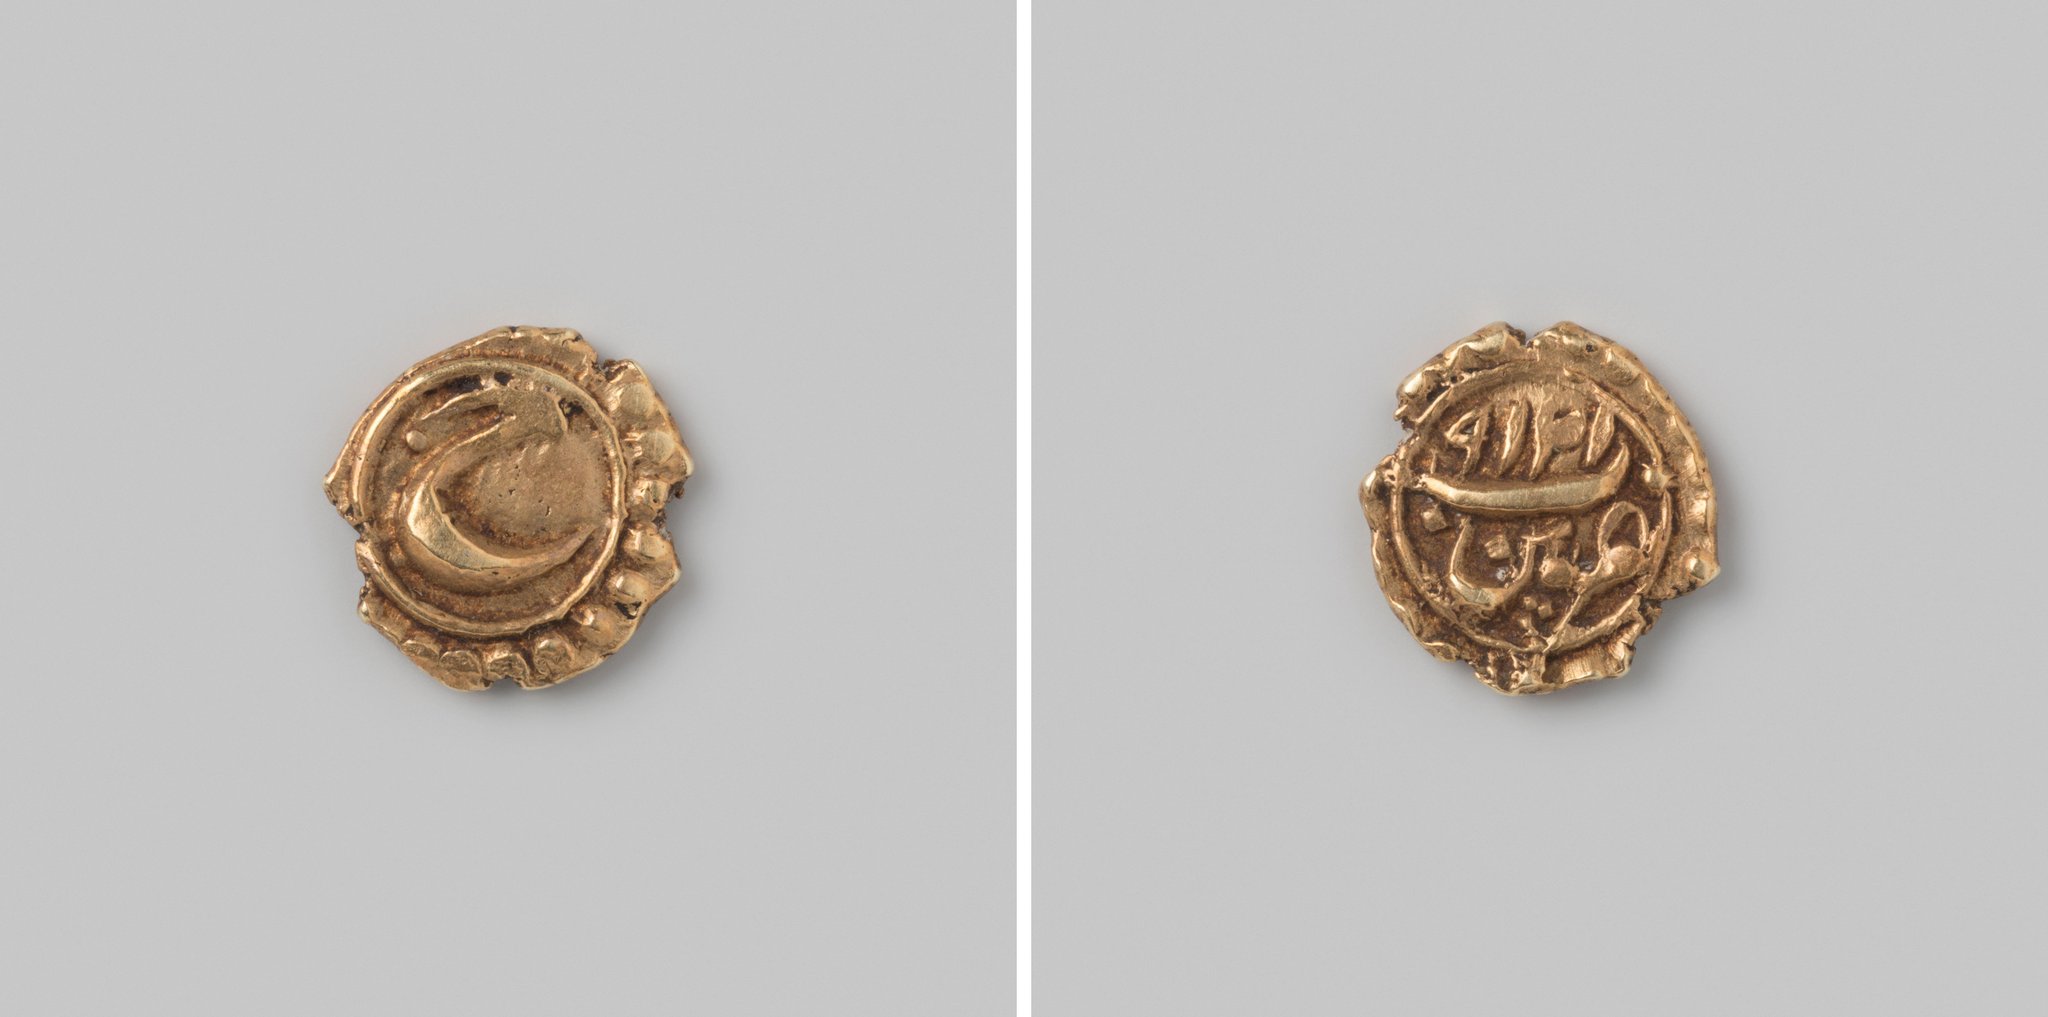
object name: coin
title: Gouden fanam uit Mysore in India van Tipu Sultan,1791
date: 1791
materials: gold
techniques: striking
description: Gouden munt. Voorzijde: het Arabische letterteken voor H. Keerzijde: in Arabische lettertekens in twee regels aanduiding muntplaats:Patan [=Seringapatam]. Bovenaan jaartal: 1219 AM [=1791], geschreven van rechts naar links.